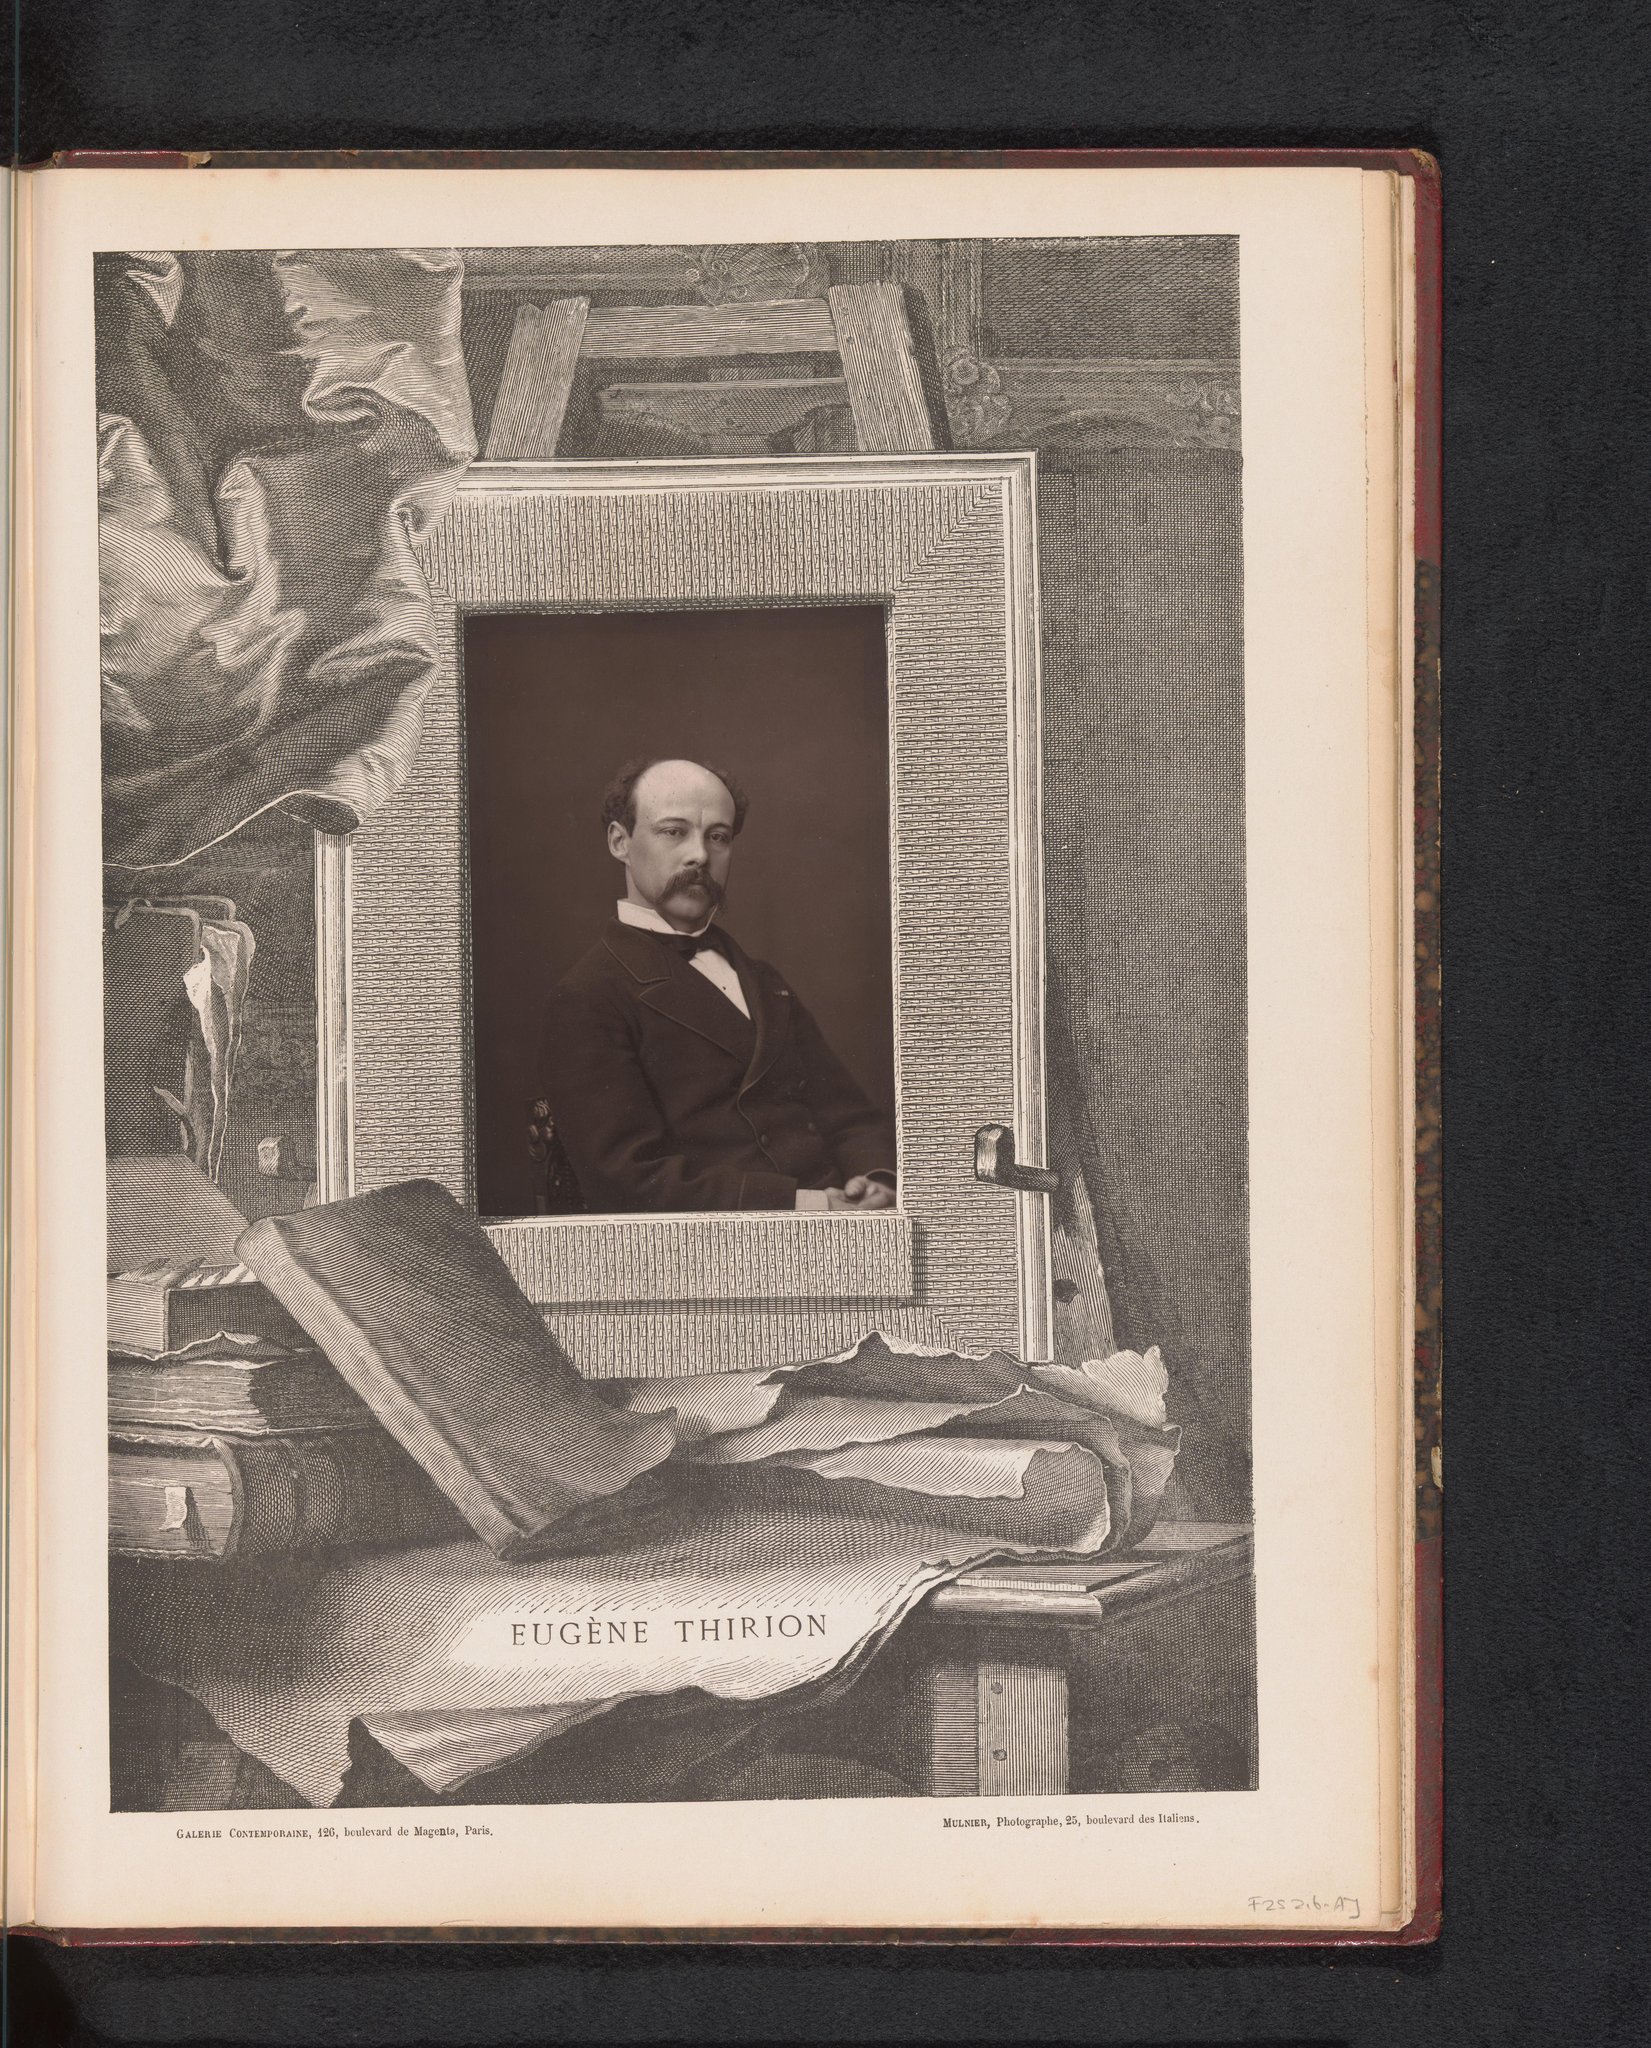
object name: page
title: Eugène Thirion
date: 1867-1876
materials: paper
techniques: printing block, woodburytype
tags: painter, eugène romain thirion, adult man, historical persons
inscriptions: inscription: ‘Galerie Contemporaine, 126, boulevard de Magenta, Paris.’